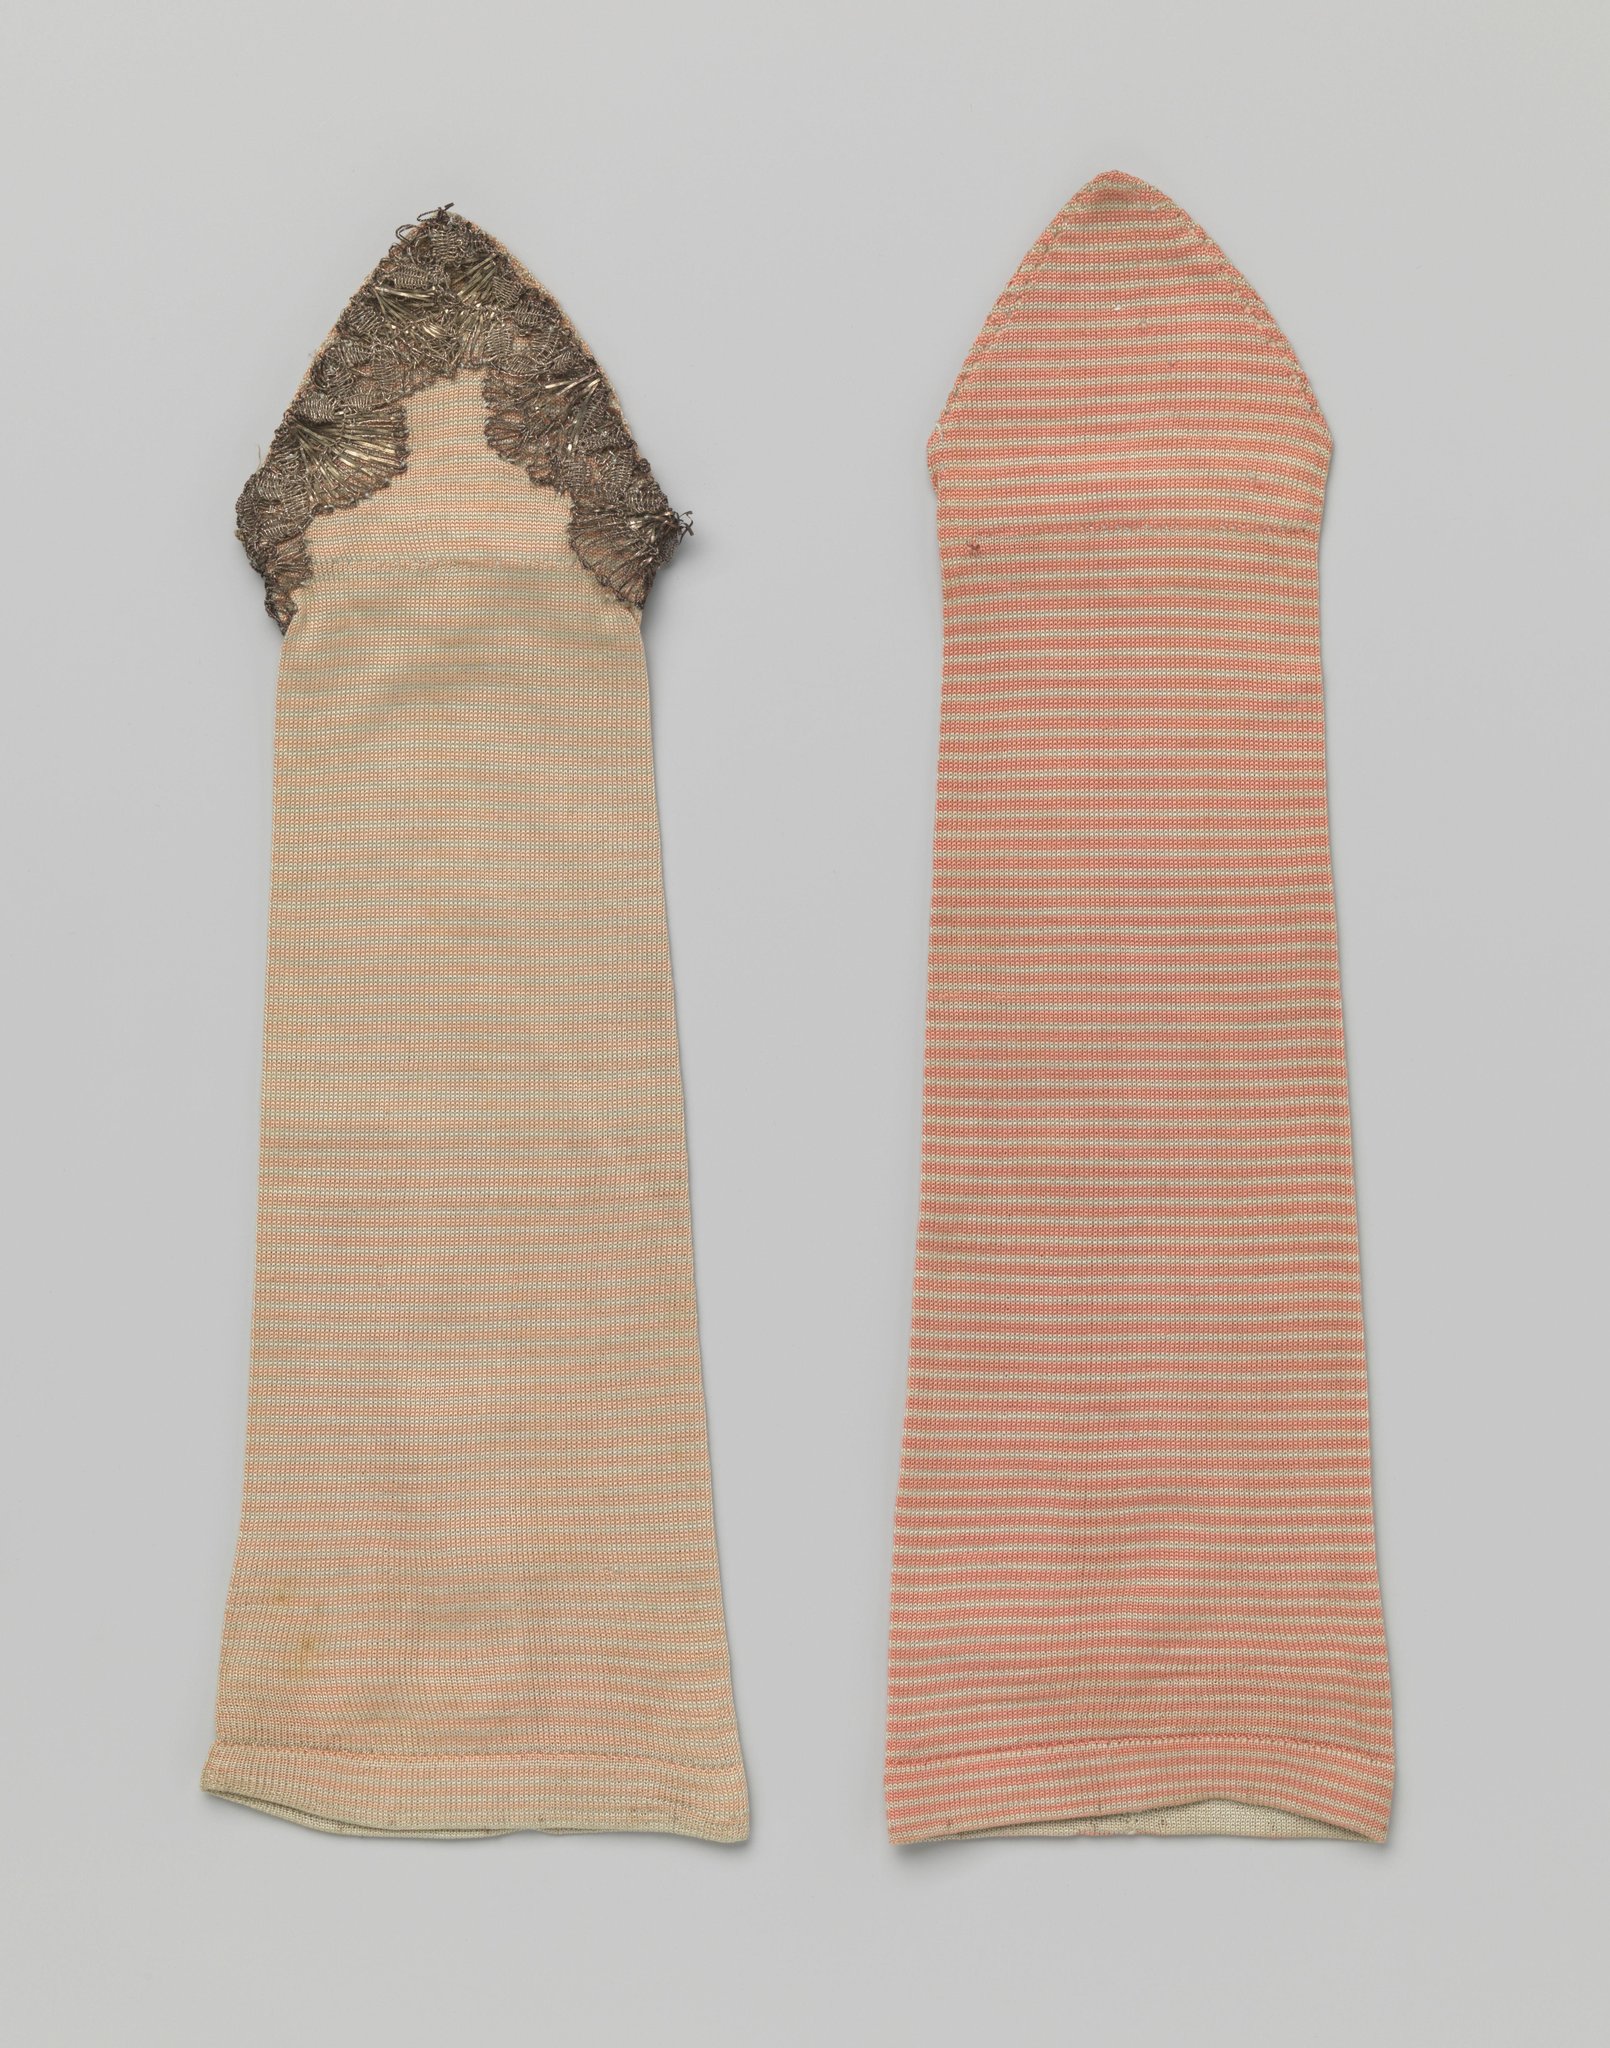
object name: mitt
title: Mitaine van roze en wit gestreepte zijde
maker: Anonymous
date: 1800-1820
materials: silk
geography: zaanstreek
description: Mitaine van roze en wit gestreepte zijde, afgezet met zilvergalon.